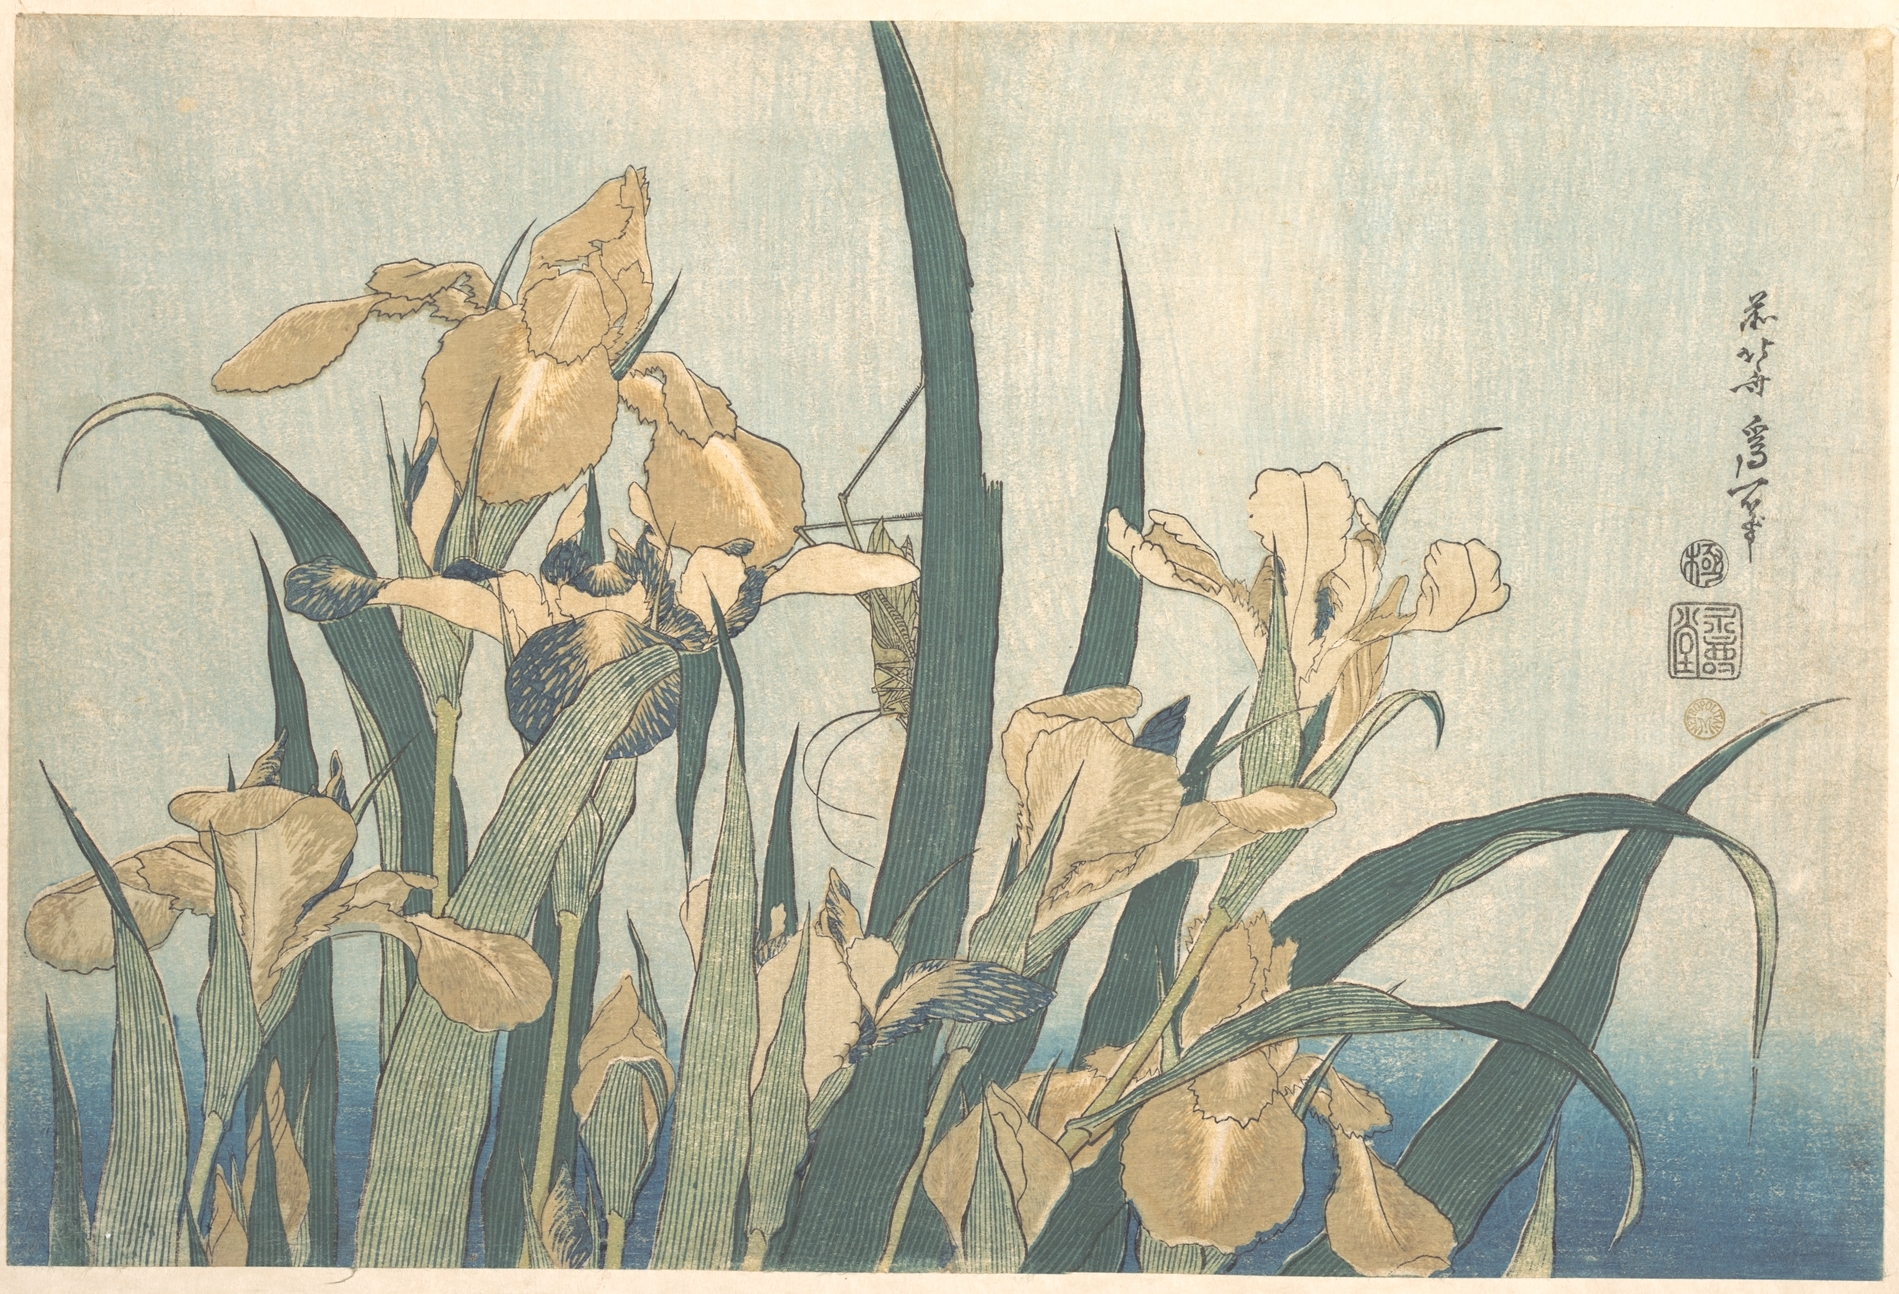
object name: print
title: Grasshopper and Iris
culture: japanese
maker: katsushika hokusai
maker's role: artist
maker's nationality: japanese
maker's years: 1760-1849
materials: ink, paper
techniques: woodblock print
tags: insects,flowers